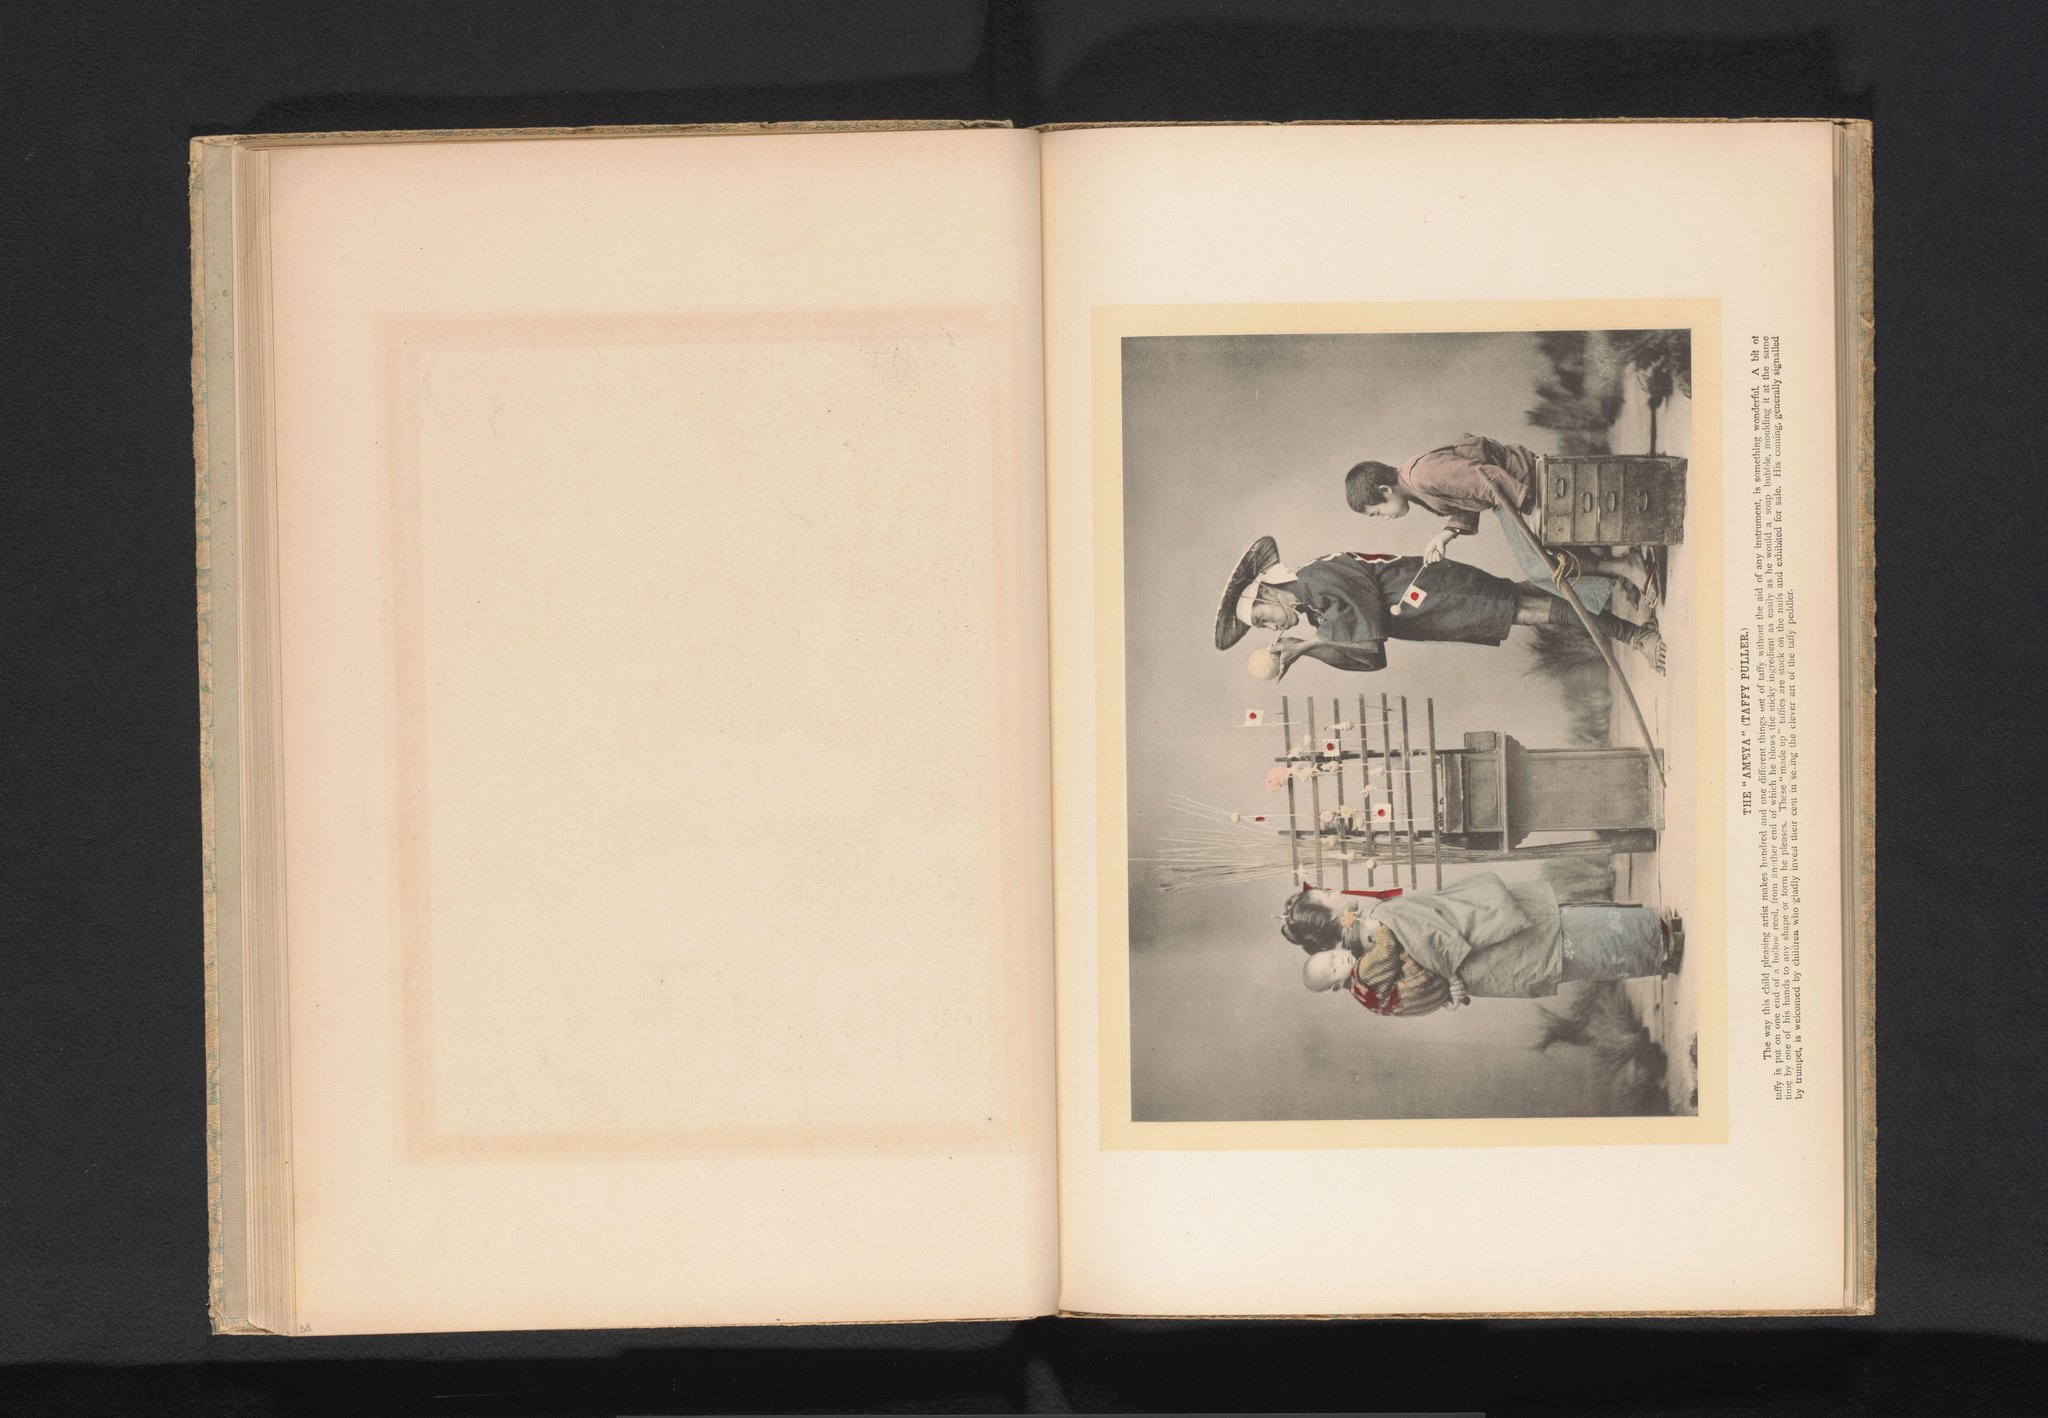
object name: page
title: The "Ameya" (Taffy Puller)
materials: paper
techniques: photograph, lithograph, hand coloring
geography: tokyo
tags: sugar-candy, merchant, salesman, japan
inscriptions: inscription: ‘The way (...) taffy peddler.’